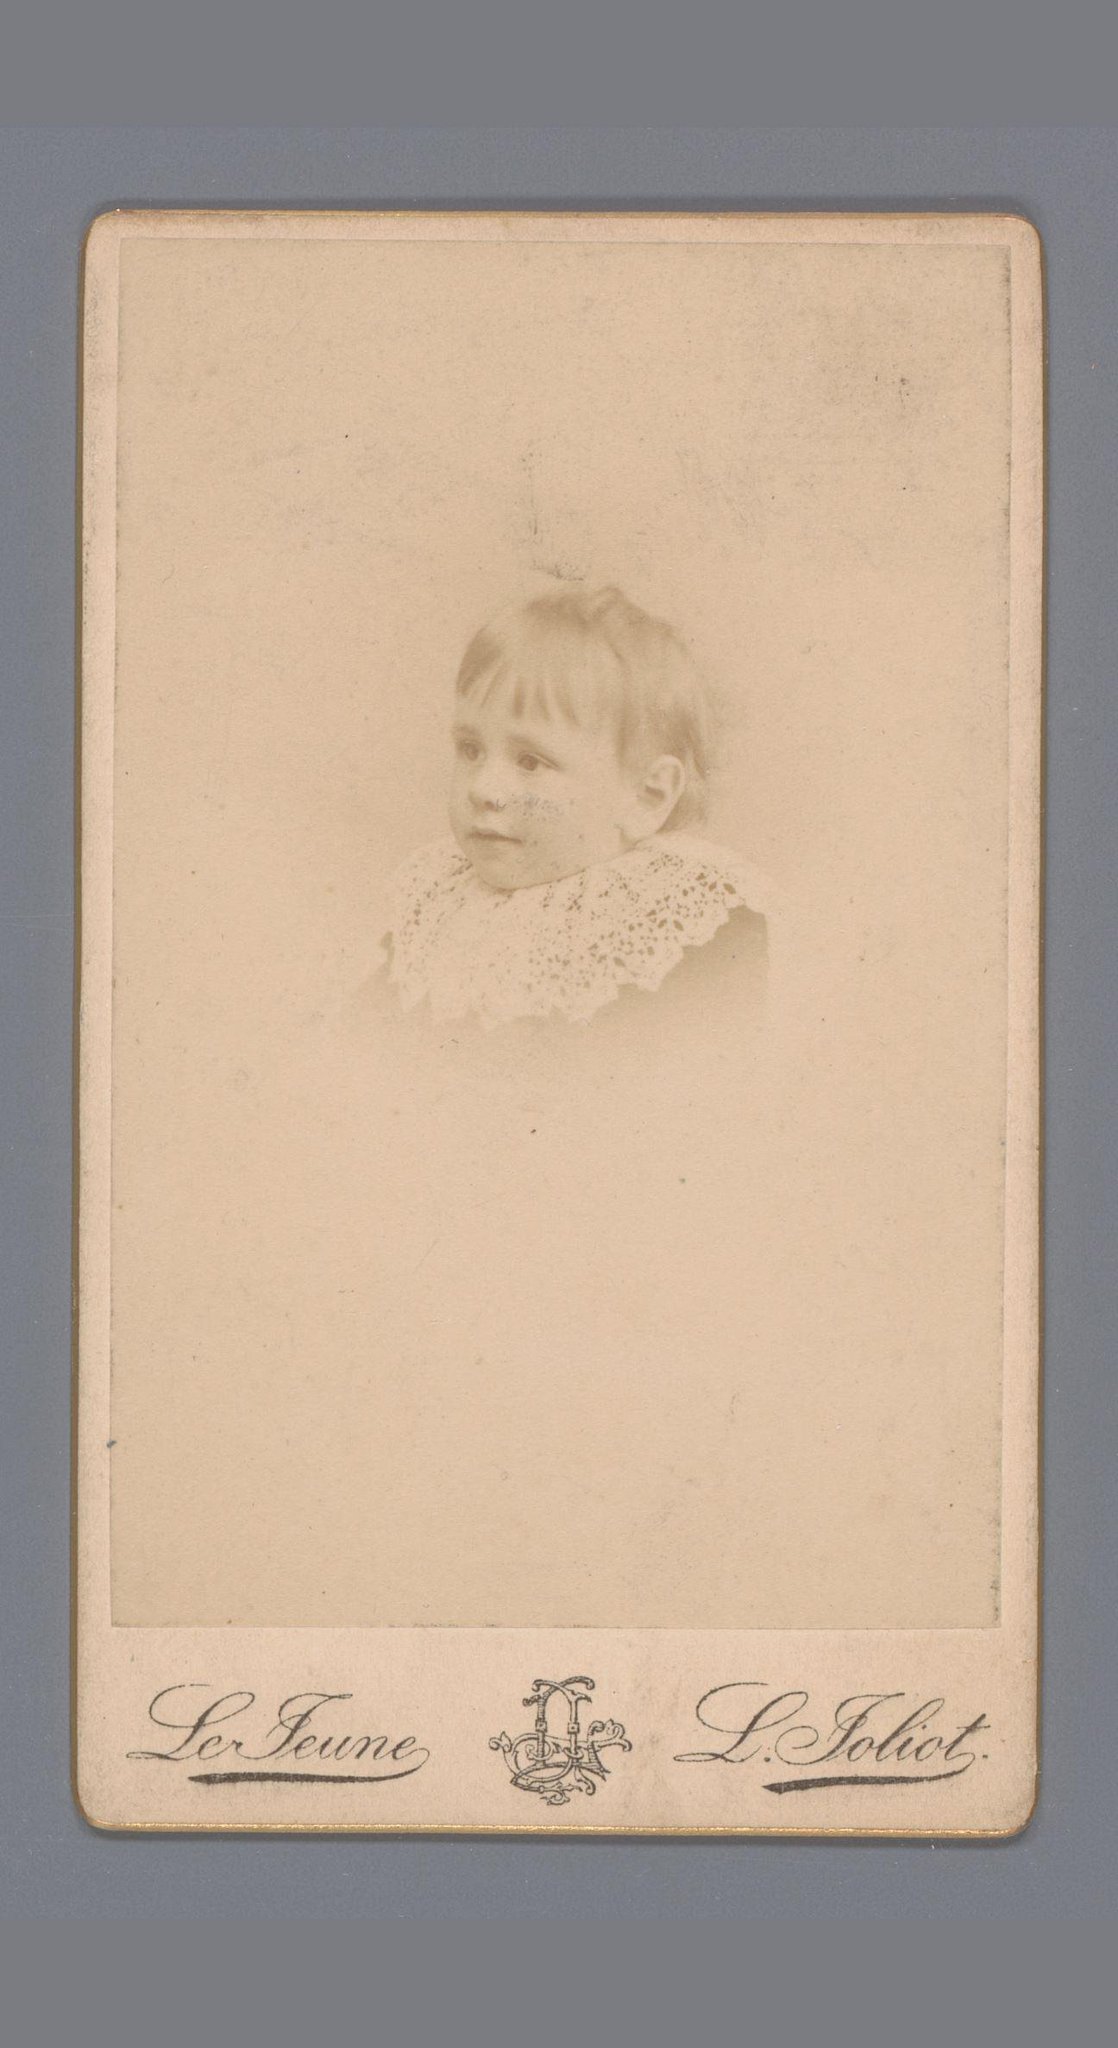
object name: photograph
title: Portret van een onbekend kind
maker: leon joliot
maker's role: fotograaf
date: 1874-1890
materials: cardboard, paper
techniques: albumen print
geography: paris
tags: child, historical persons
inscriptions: inscription: ‘Le Jeune L. Joliot.’, inscription: ‘LJ/ Le Jeune/ Le. JOLIOT, Succr./ 350, Rue St. honoré, 350/ près la Place Vendôme/ PARIS.’